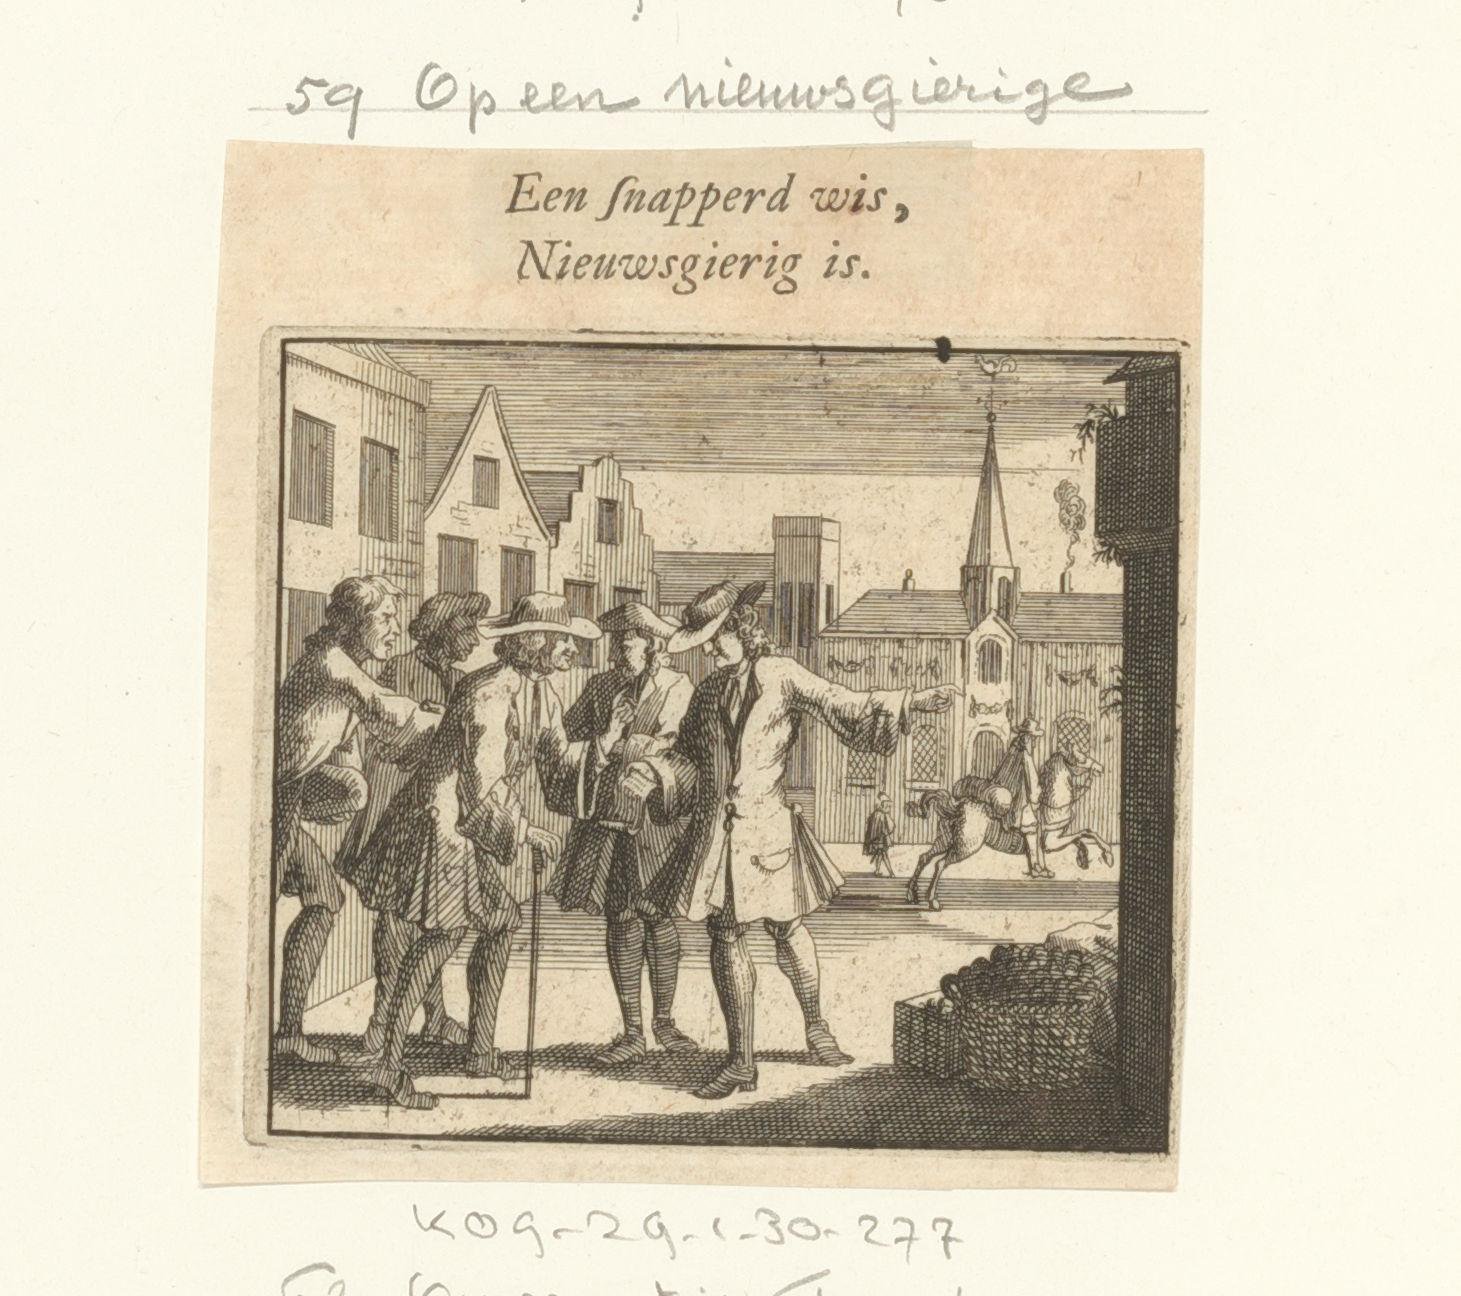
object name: print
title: Vijf mannen bespreken iets op straat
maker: cornelis huyberts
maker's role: print maker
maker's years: 1669-1709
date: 1725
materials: paper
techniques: etching, letterpress printing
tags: slander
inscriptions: stamp, collector's mark: Lugt 1641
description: Prent uit: Graauwhart, Hendrik. Voorbeeldelyke zeede-lessen, genoomen uyt den eersten toestand des werelds (...). Amsterdam: Johannes Ratelband, 1725. Prent ook gebruikt voor eerdere en (1709) latere uitgave (1756, 1761 en 1764).